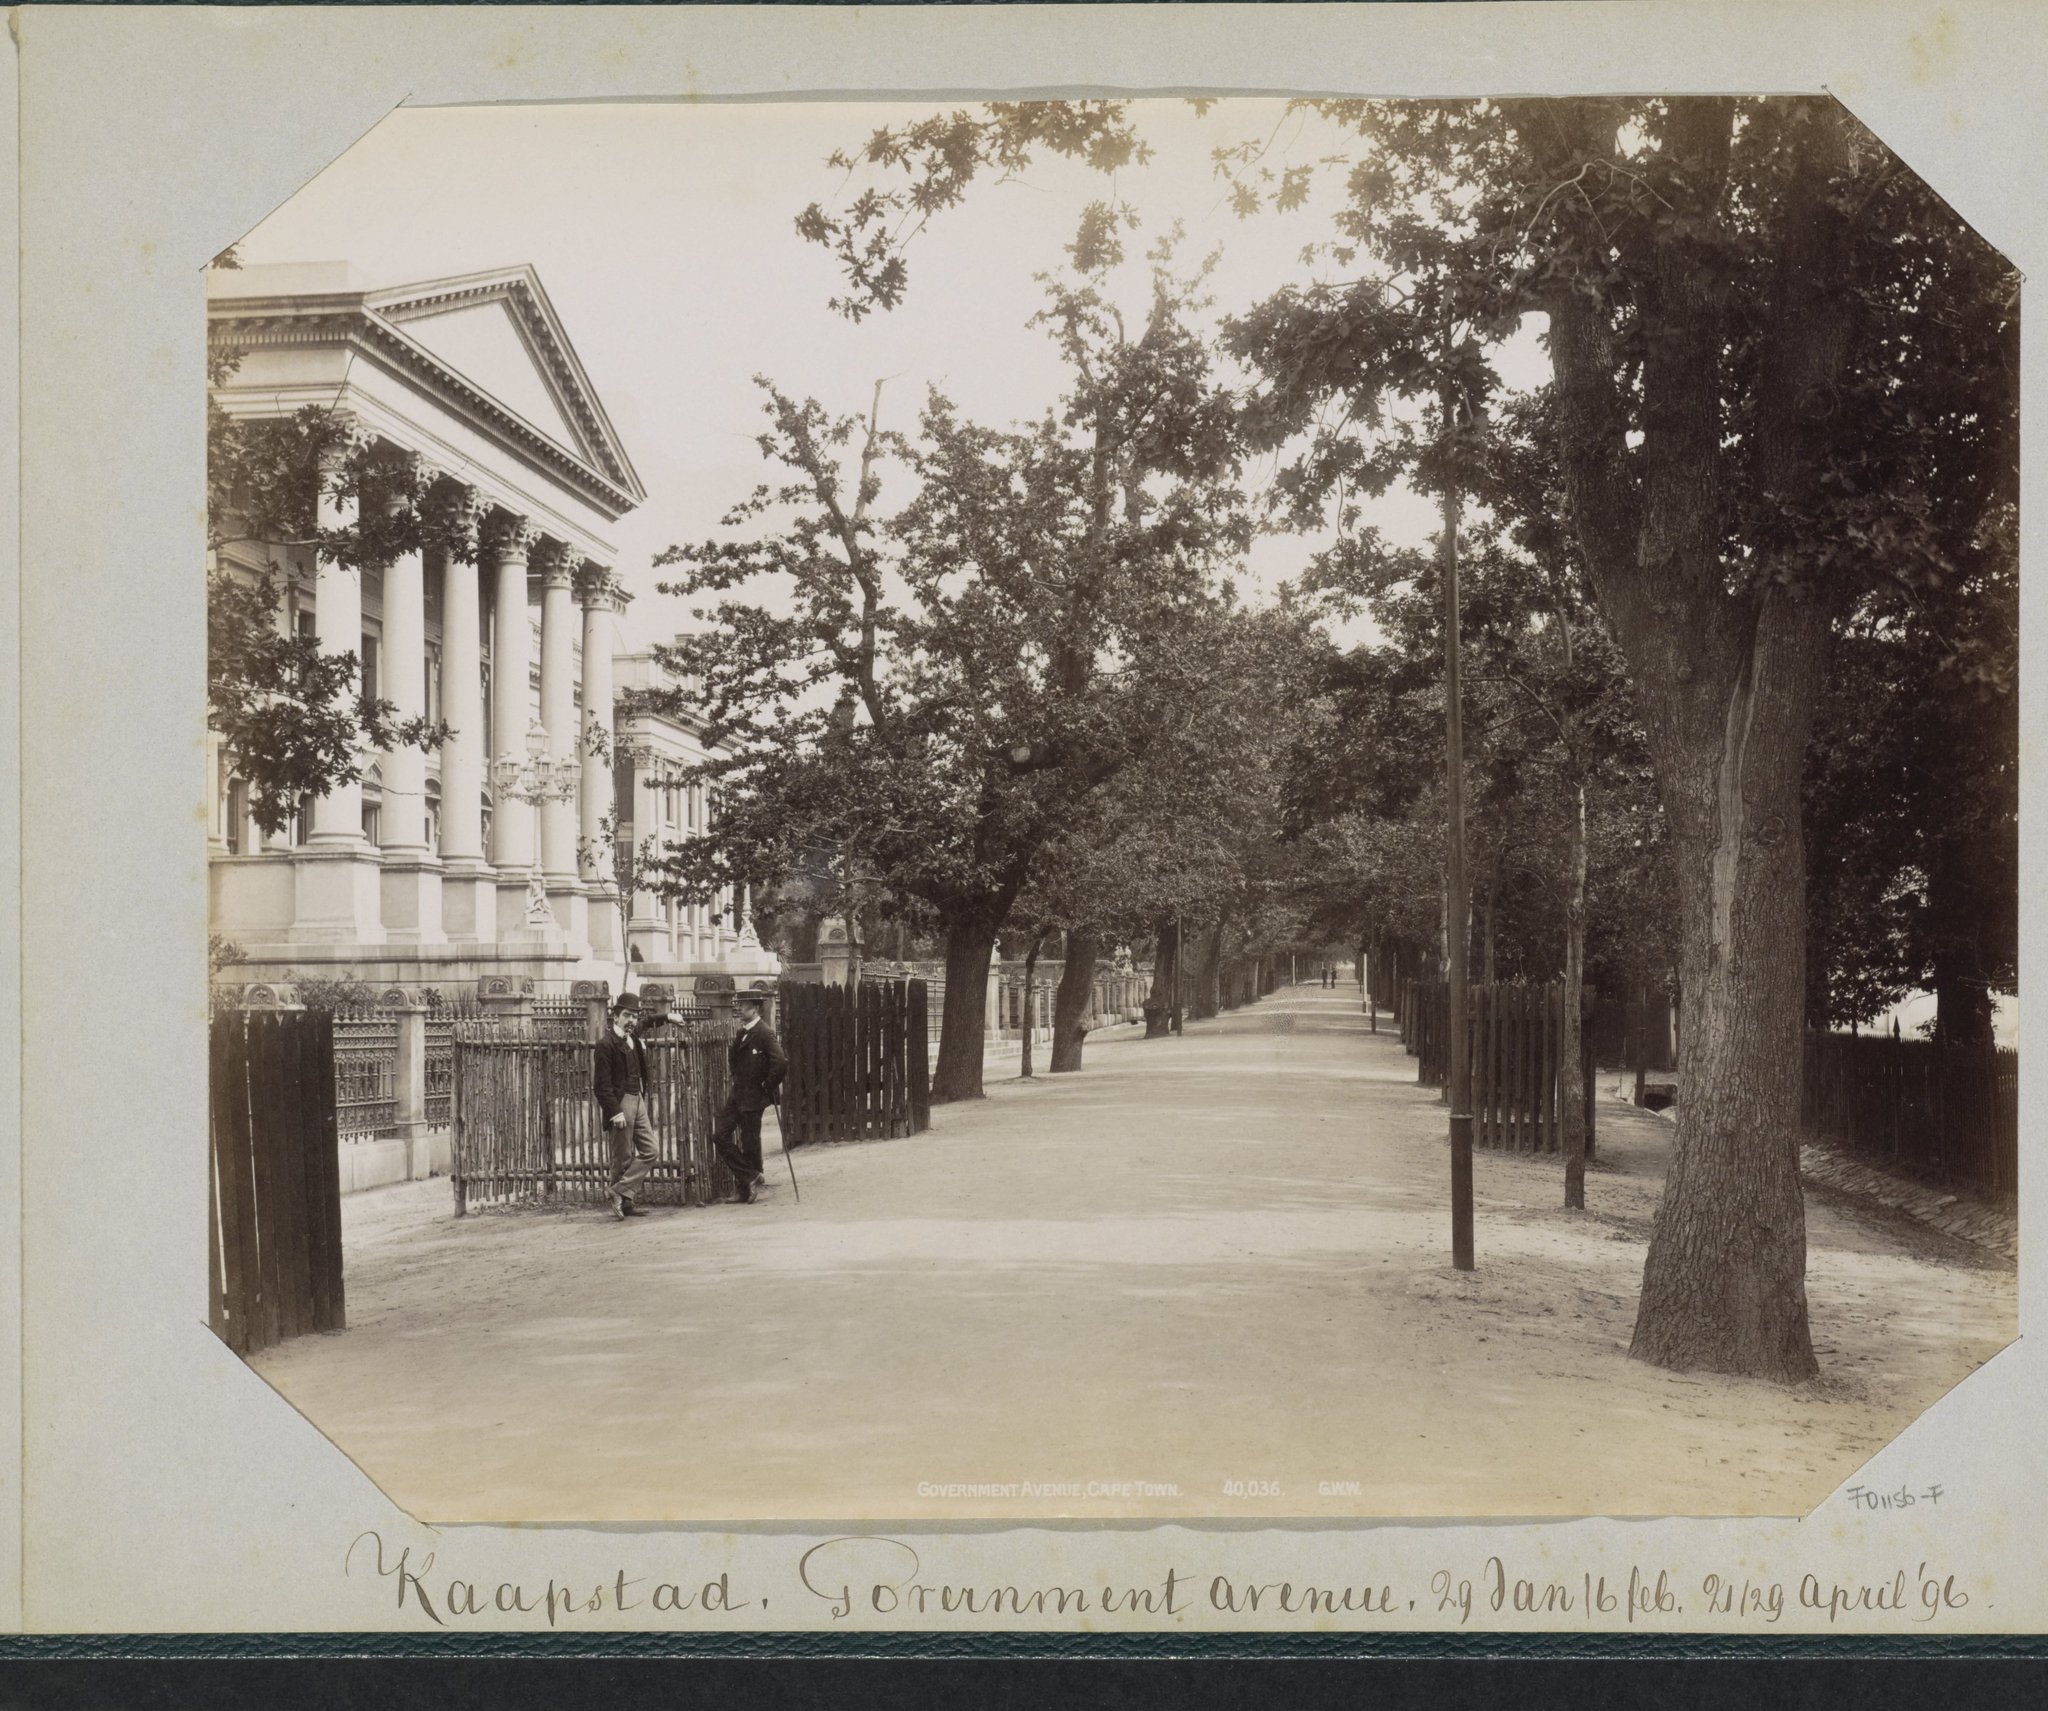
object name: photograph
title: Straatgezicht van Government Avenue te Kaapstad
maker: george washington wilson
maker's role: publisher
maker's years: 1823-1893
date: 1870-1893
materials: photographic support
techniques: albumen print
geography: cape town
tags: street (+ city(-scape) with figures, staffage)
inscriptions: annotation: ‘Kaapstad, Government Avenue. 29 Jan/6 feb. 21/29 april '96’, inscription: ‘Government Avenue, Cape Town/ 20,036. G.W.W.’